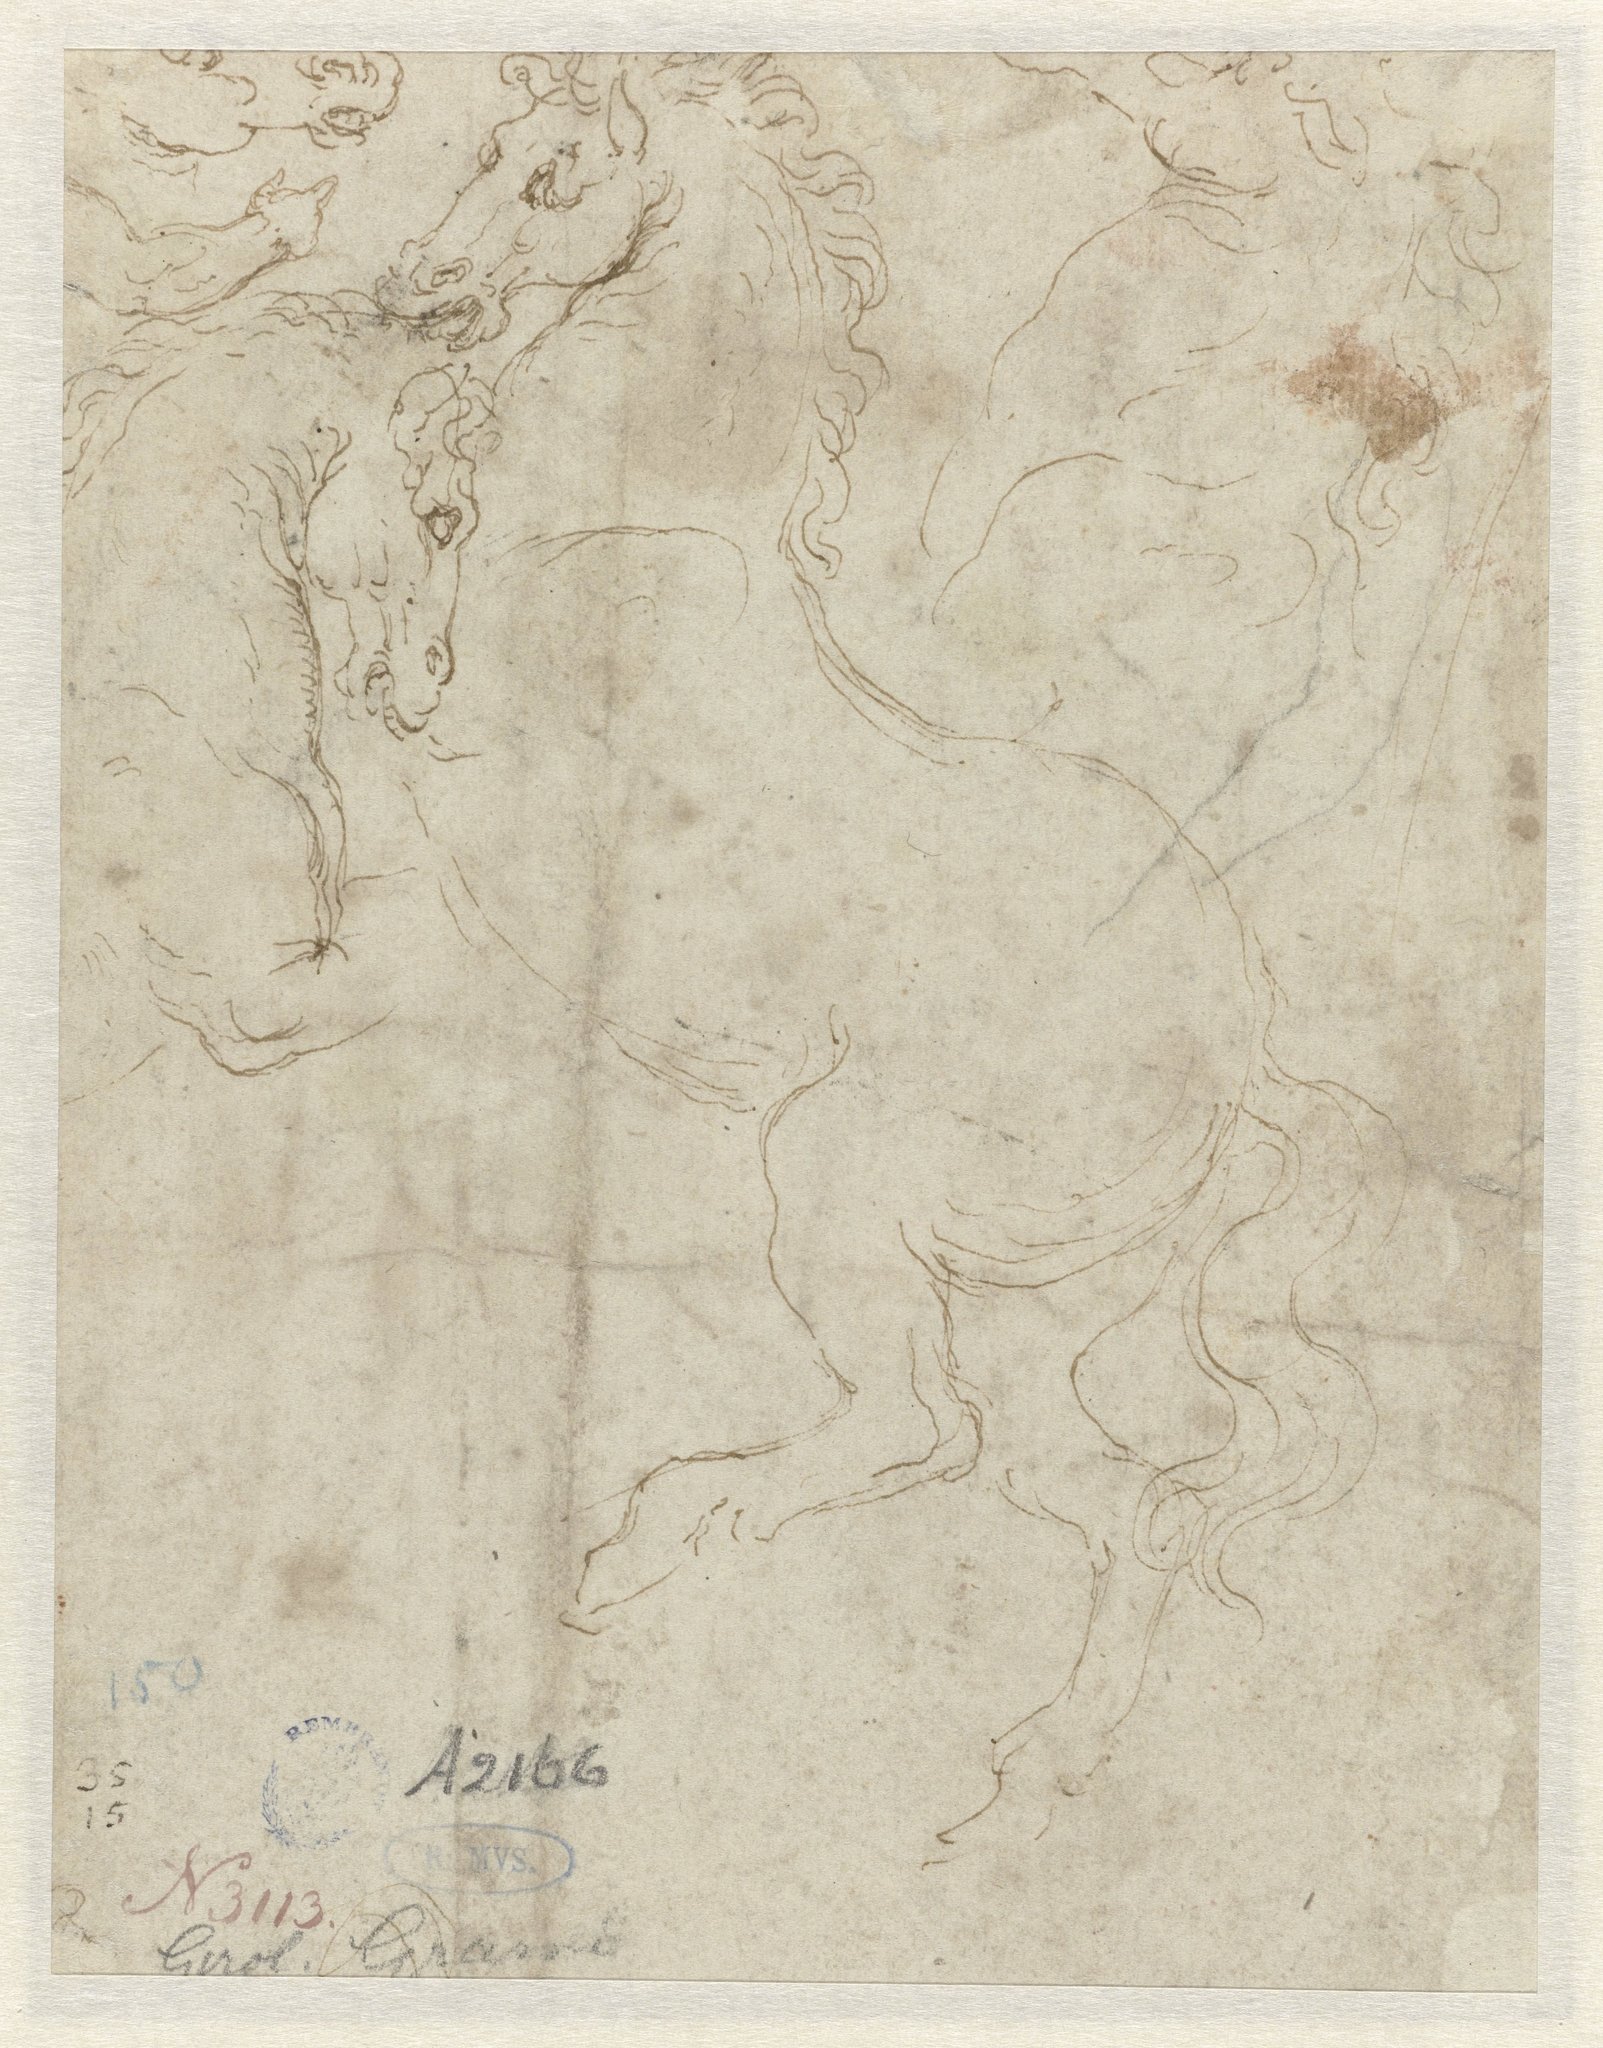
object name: drawing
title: Vier hoofden van paarden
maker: girolamo da carpi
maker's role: draughtsman, painter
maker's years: 1501-1556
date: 1549-1553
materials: ink, paper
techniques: pen